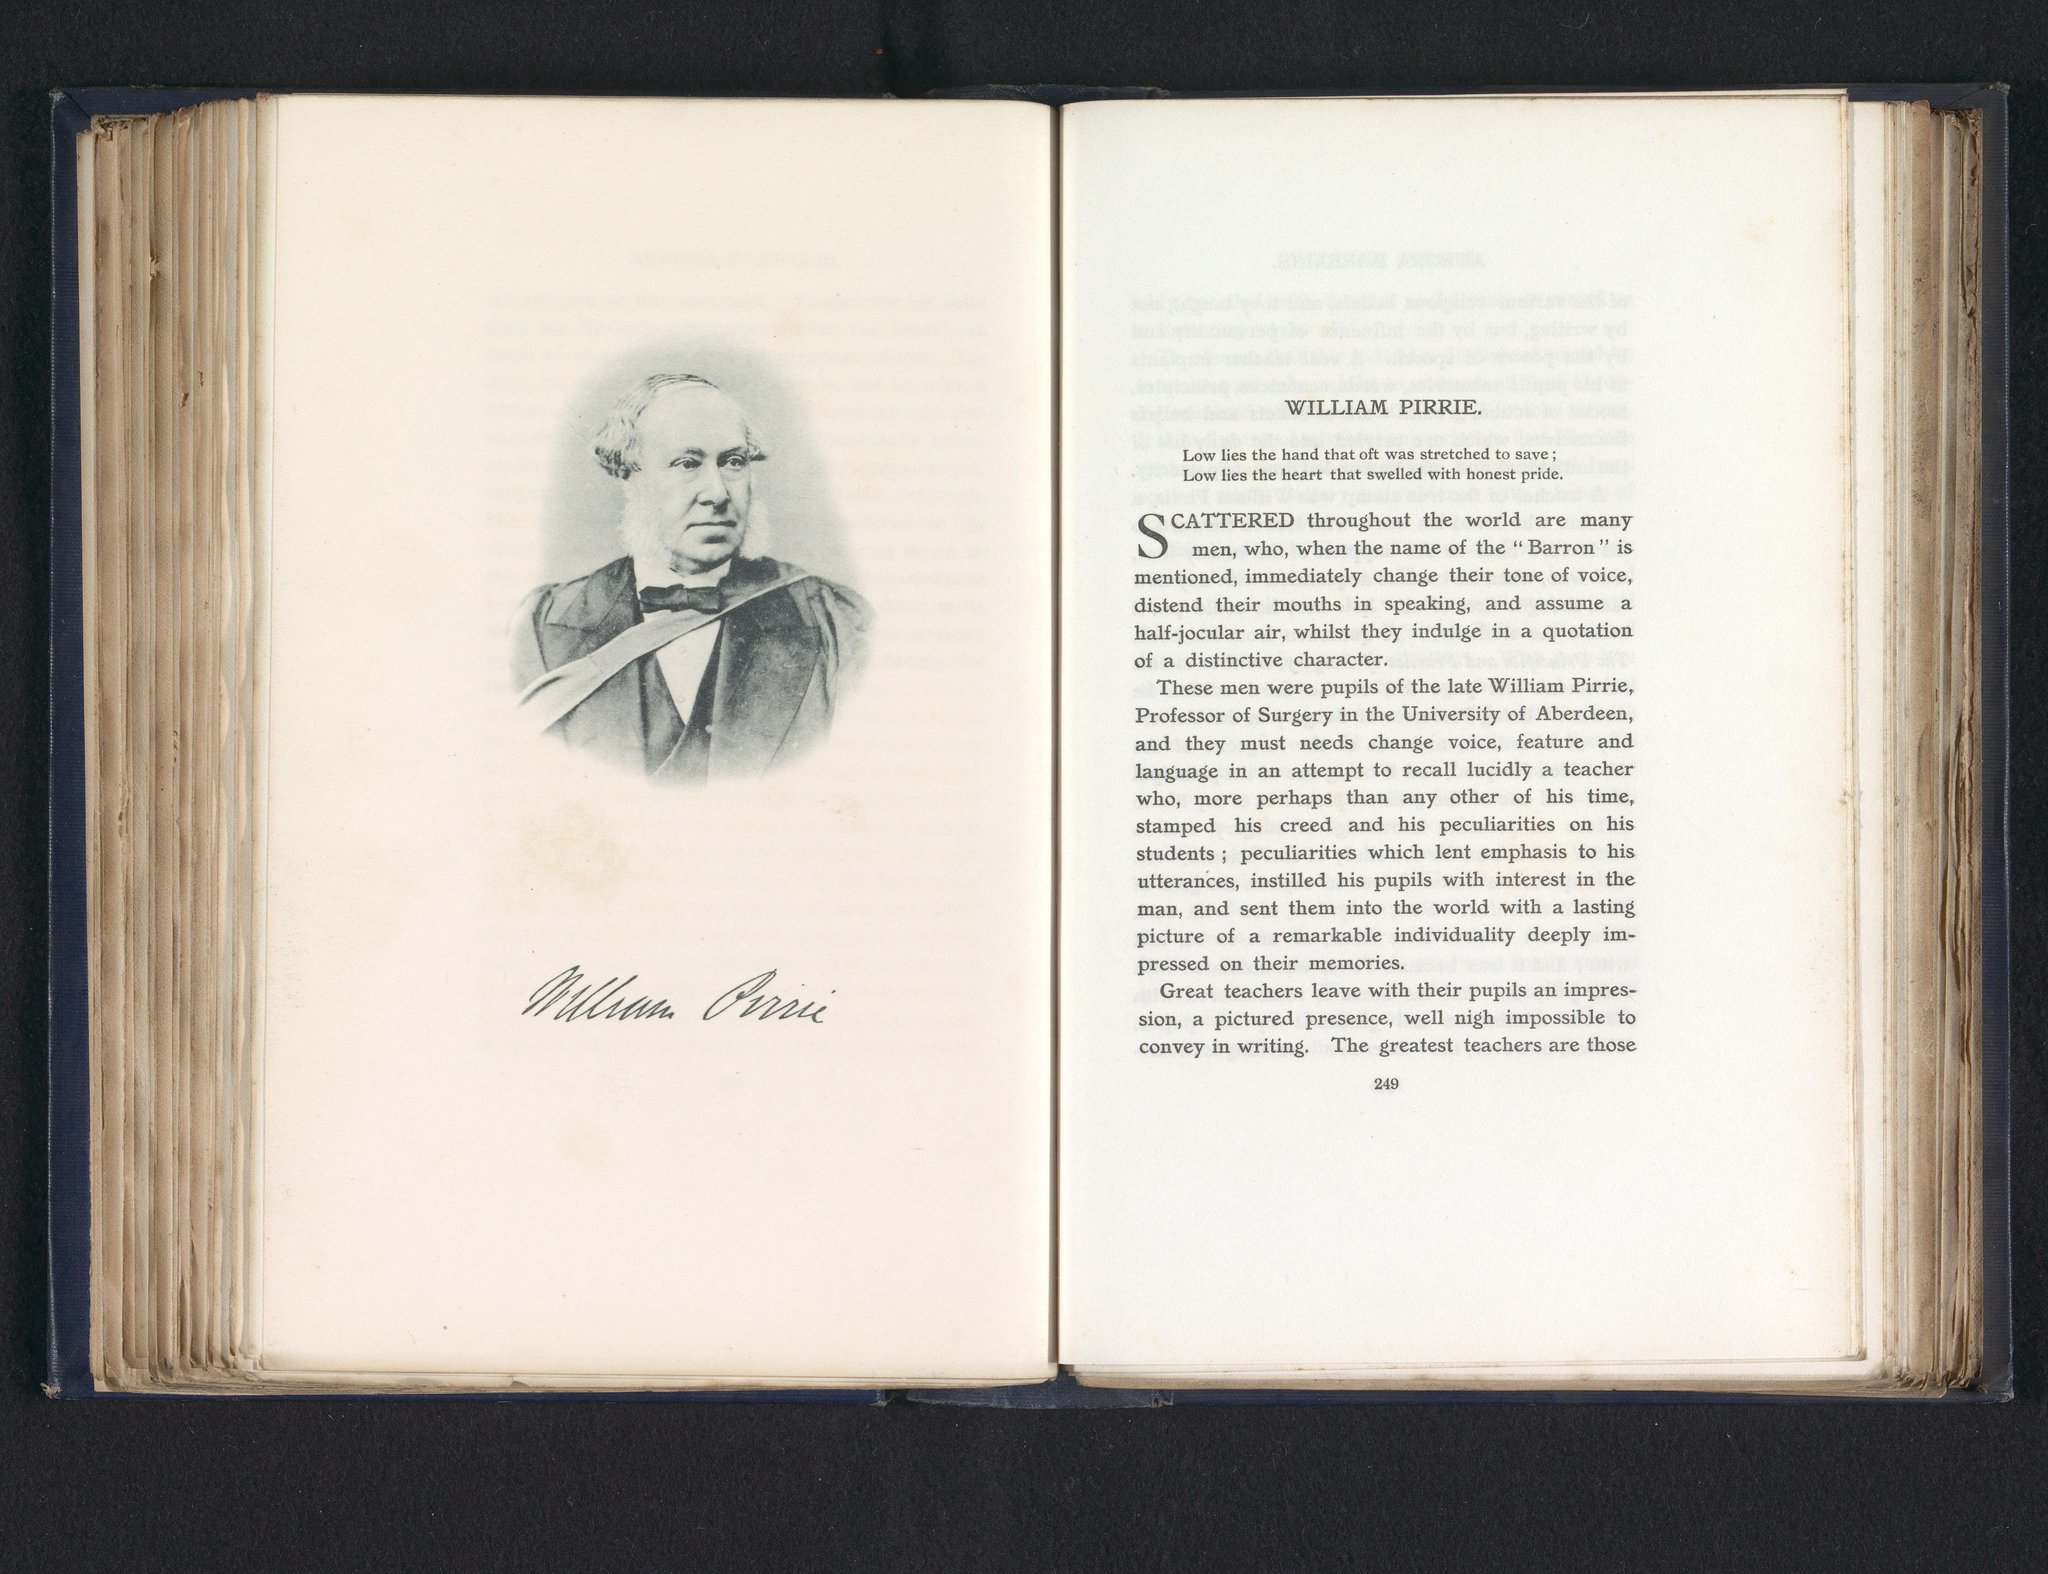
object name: photomechanical print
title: Portret van William Pirrie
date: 1872-1882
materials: paper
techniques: photograph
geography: aberdeen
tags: scholar, philosopher